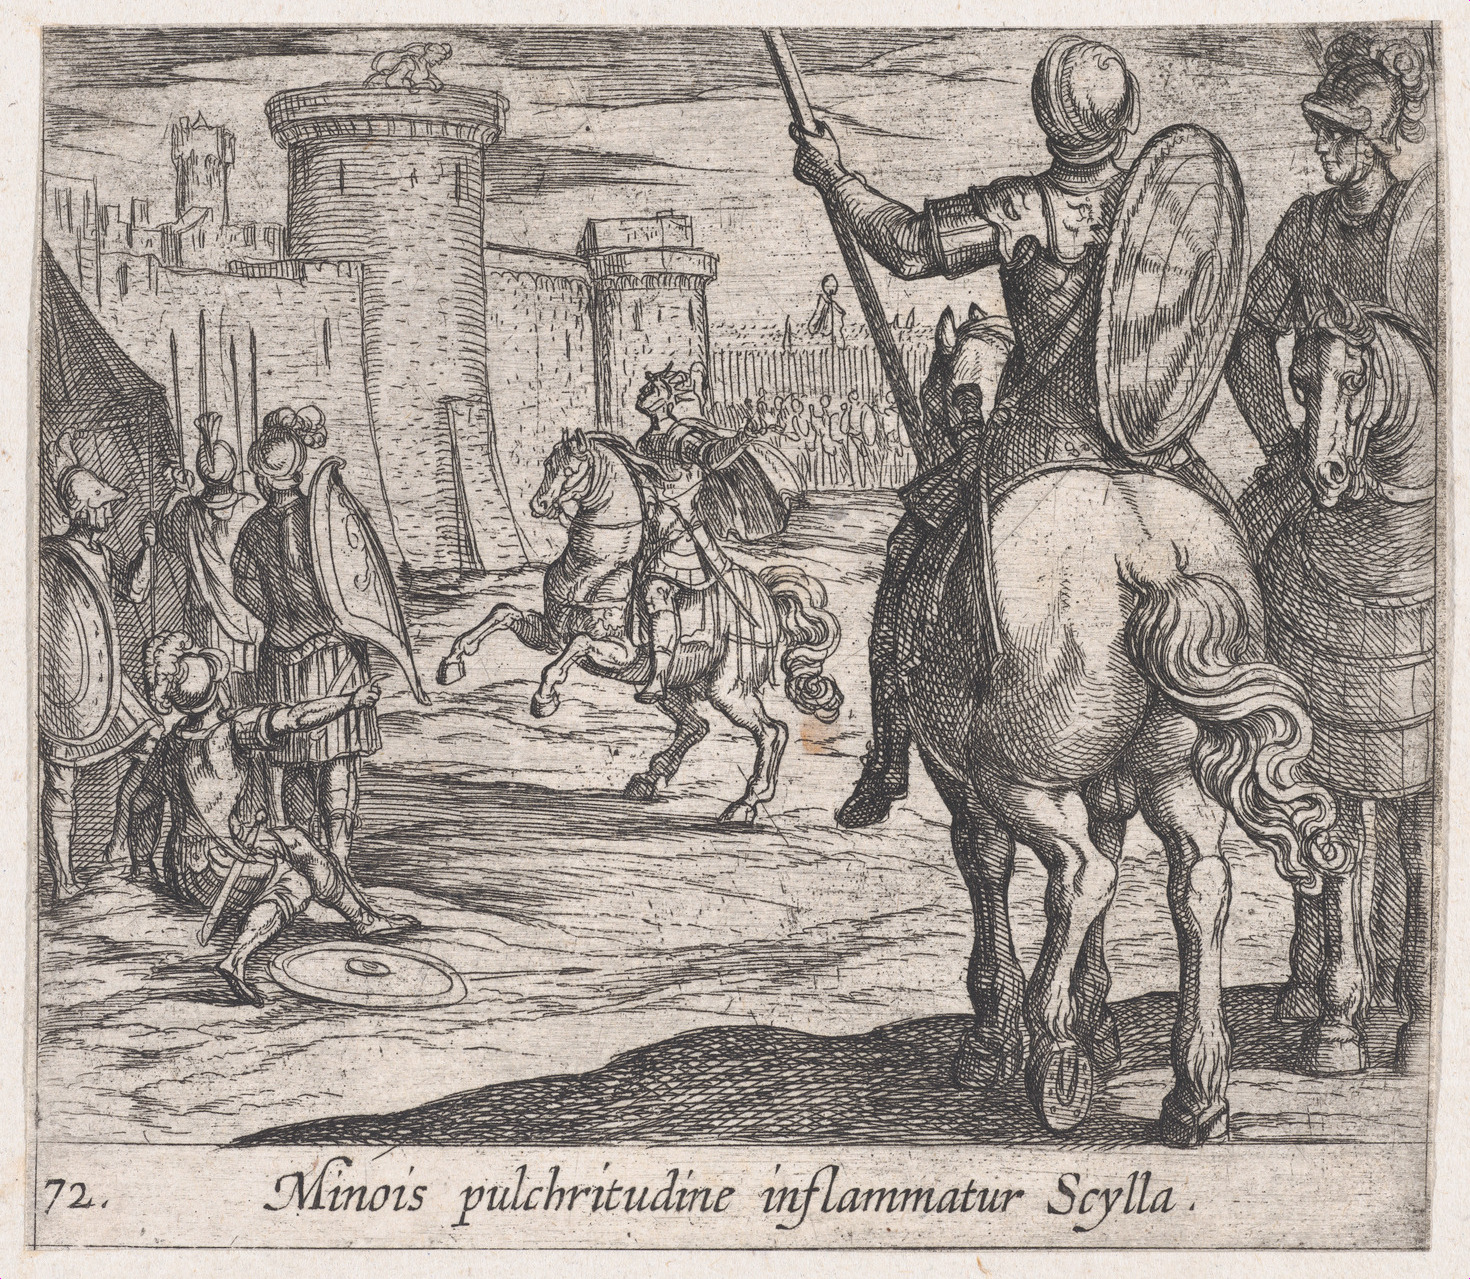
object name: print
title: Plate 72: Scylla Watching Minos from the Castle Walls (Minois pulchritudine inflammatur Scylla), from Ovid's 'Metamorphoses'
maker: antonio tempesta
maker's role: artist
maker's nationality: italian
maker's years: 1555-1630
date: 1606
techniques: etching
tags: castles,soldiers,men,horses